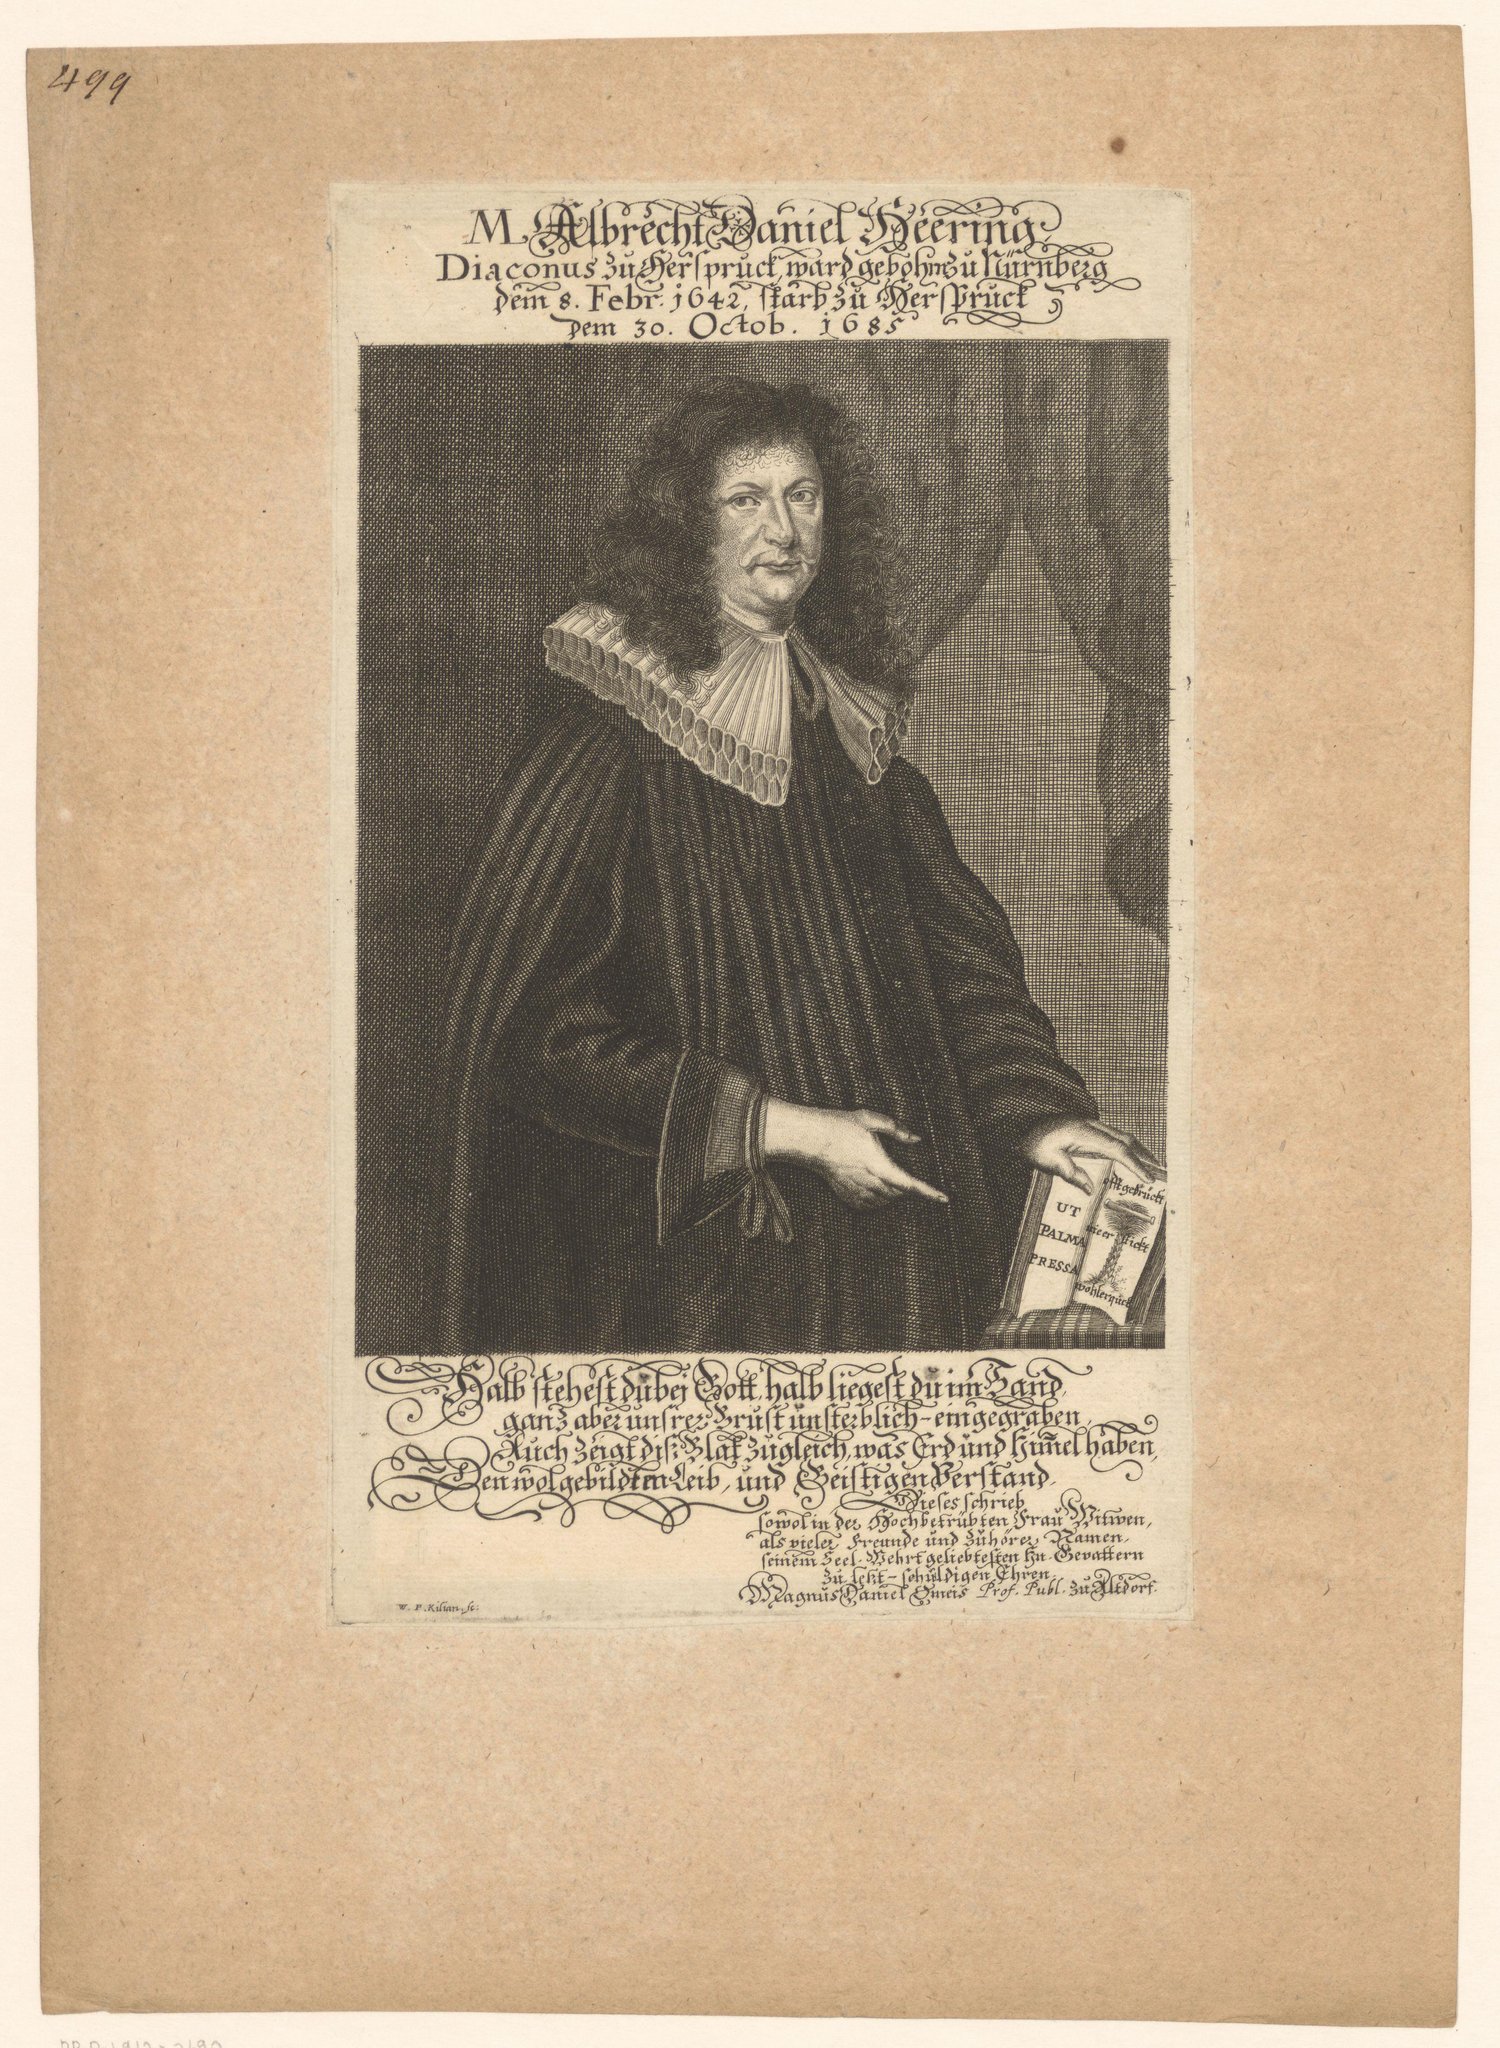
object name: print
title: Portret van Albrecht Daniel Hering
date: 1685-1732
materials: paper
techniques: engraving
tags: theologian, historical persons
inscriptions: collector's mark: Lugt 2228